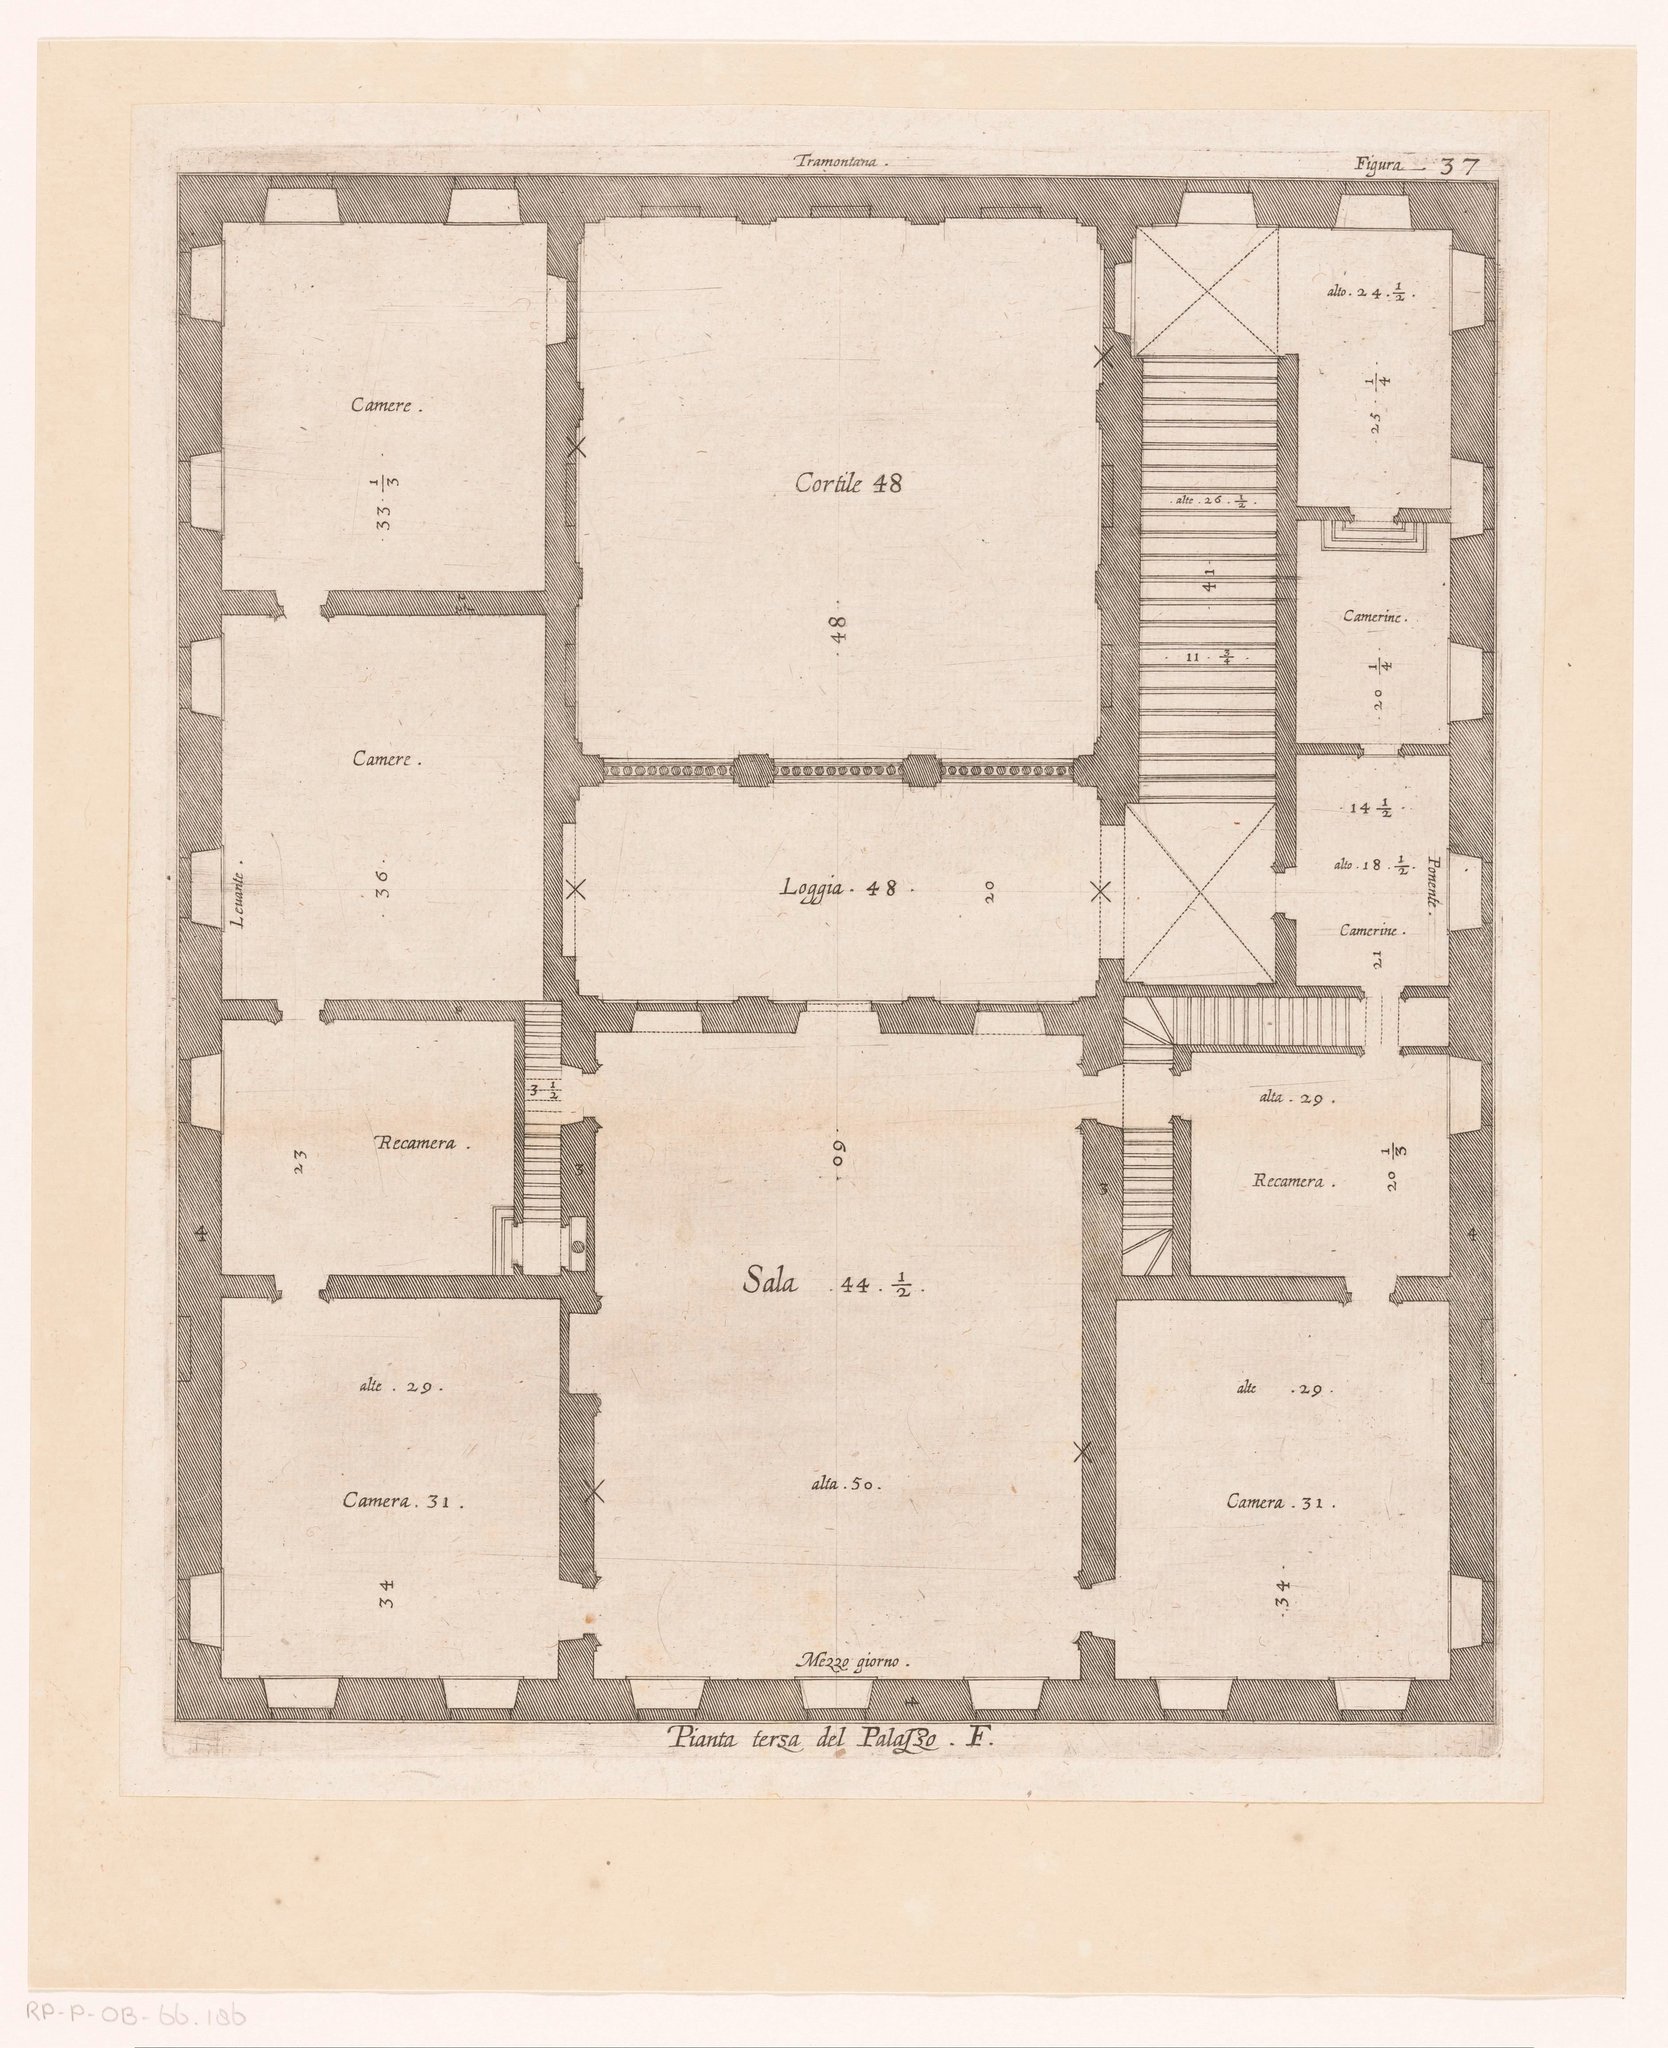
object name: ornament print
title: Plattegrond van de eerste verdieping van het Palazzo Spinola te Genua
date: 1622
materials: paper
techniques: engraving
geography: antwerp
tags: hôtel, i.e. small palace in city - aa - civic architecture: inside, plan ~ architecture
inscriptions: collector's mark: Lugt 240